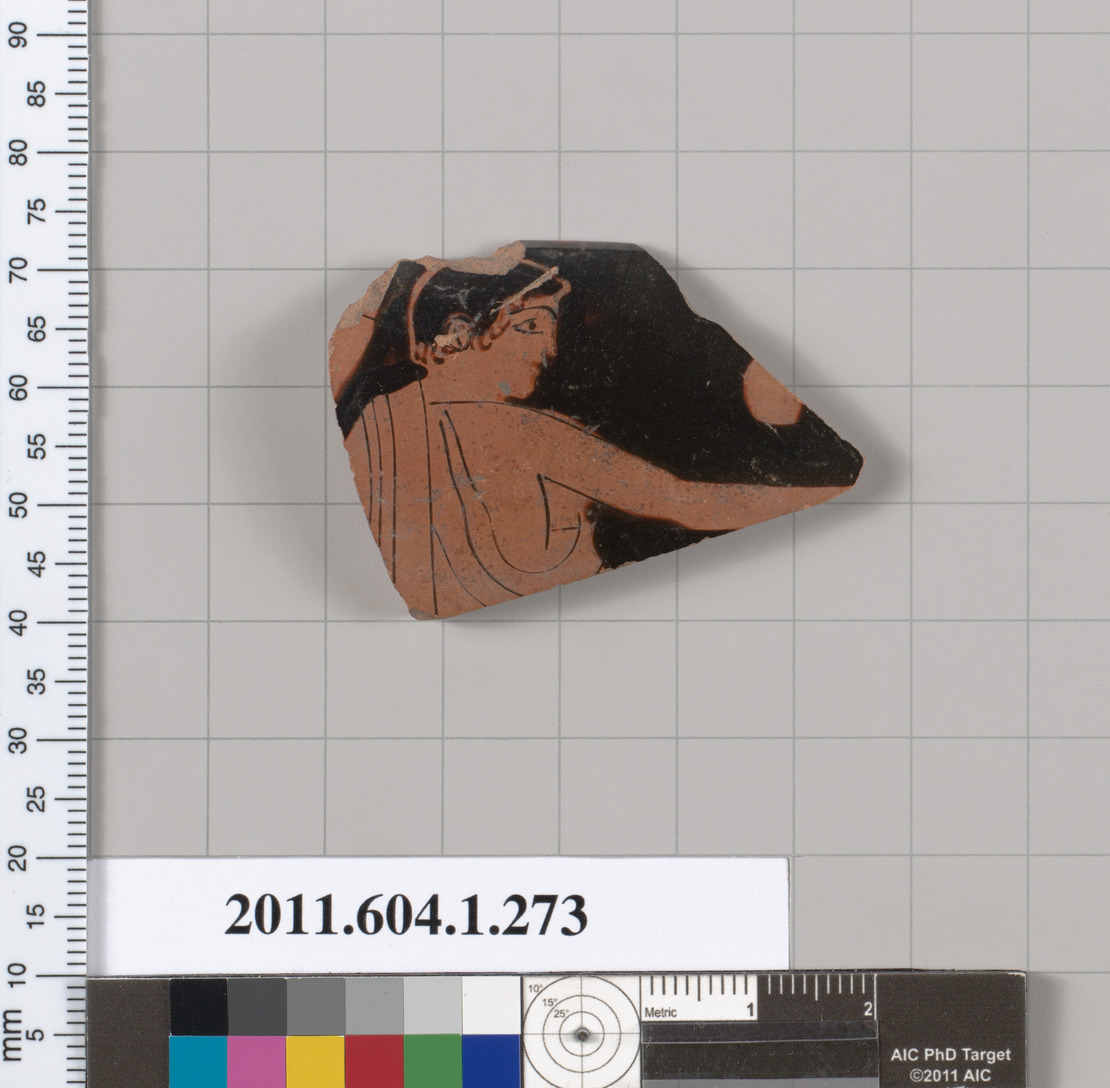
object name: kylix fragment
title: Terracotta rim fragment of a kylix (drinking cup)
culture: greek, attic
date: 475-451 BCE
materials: terracotta